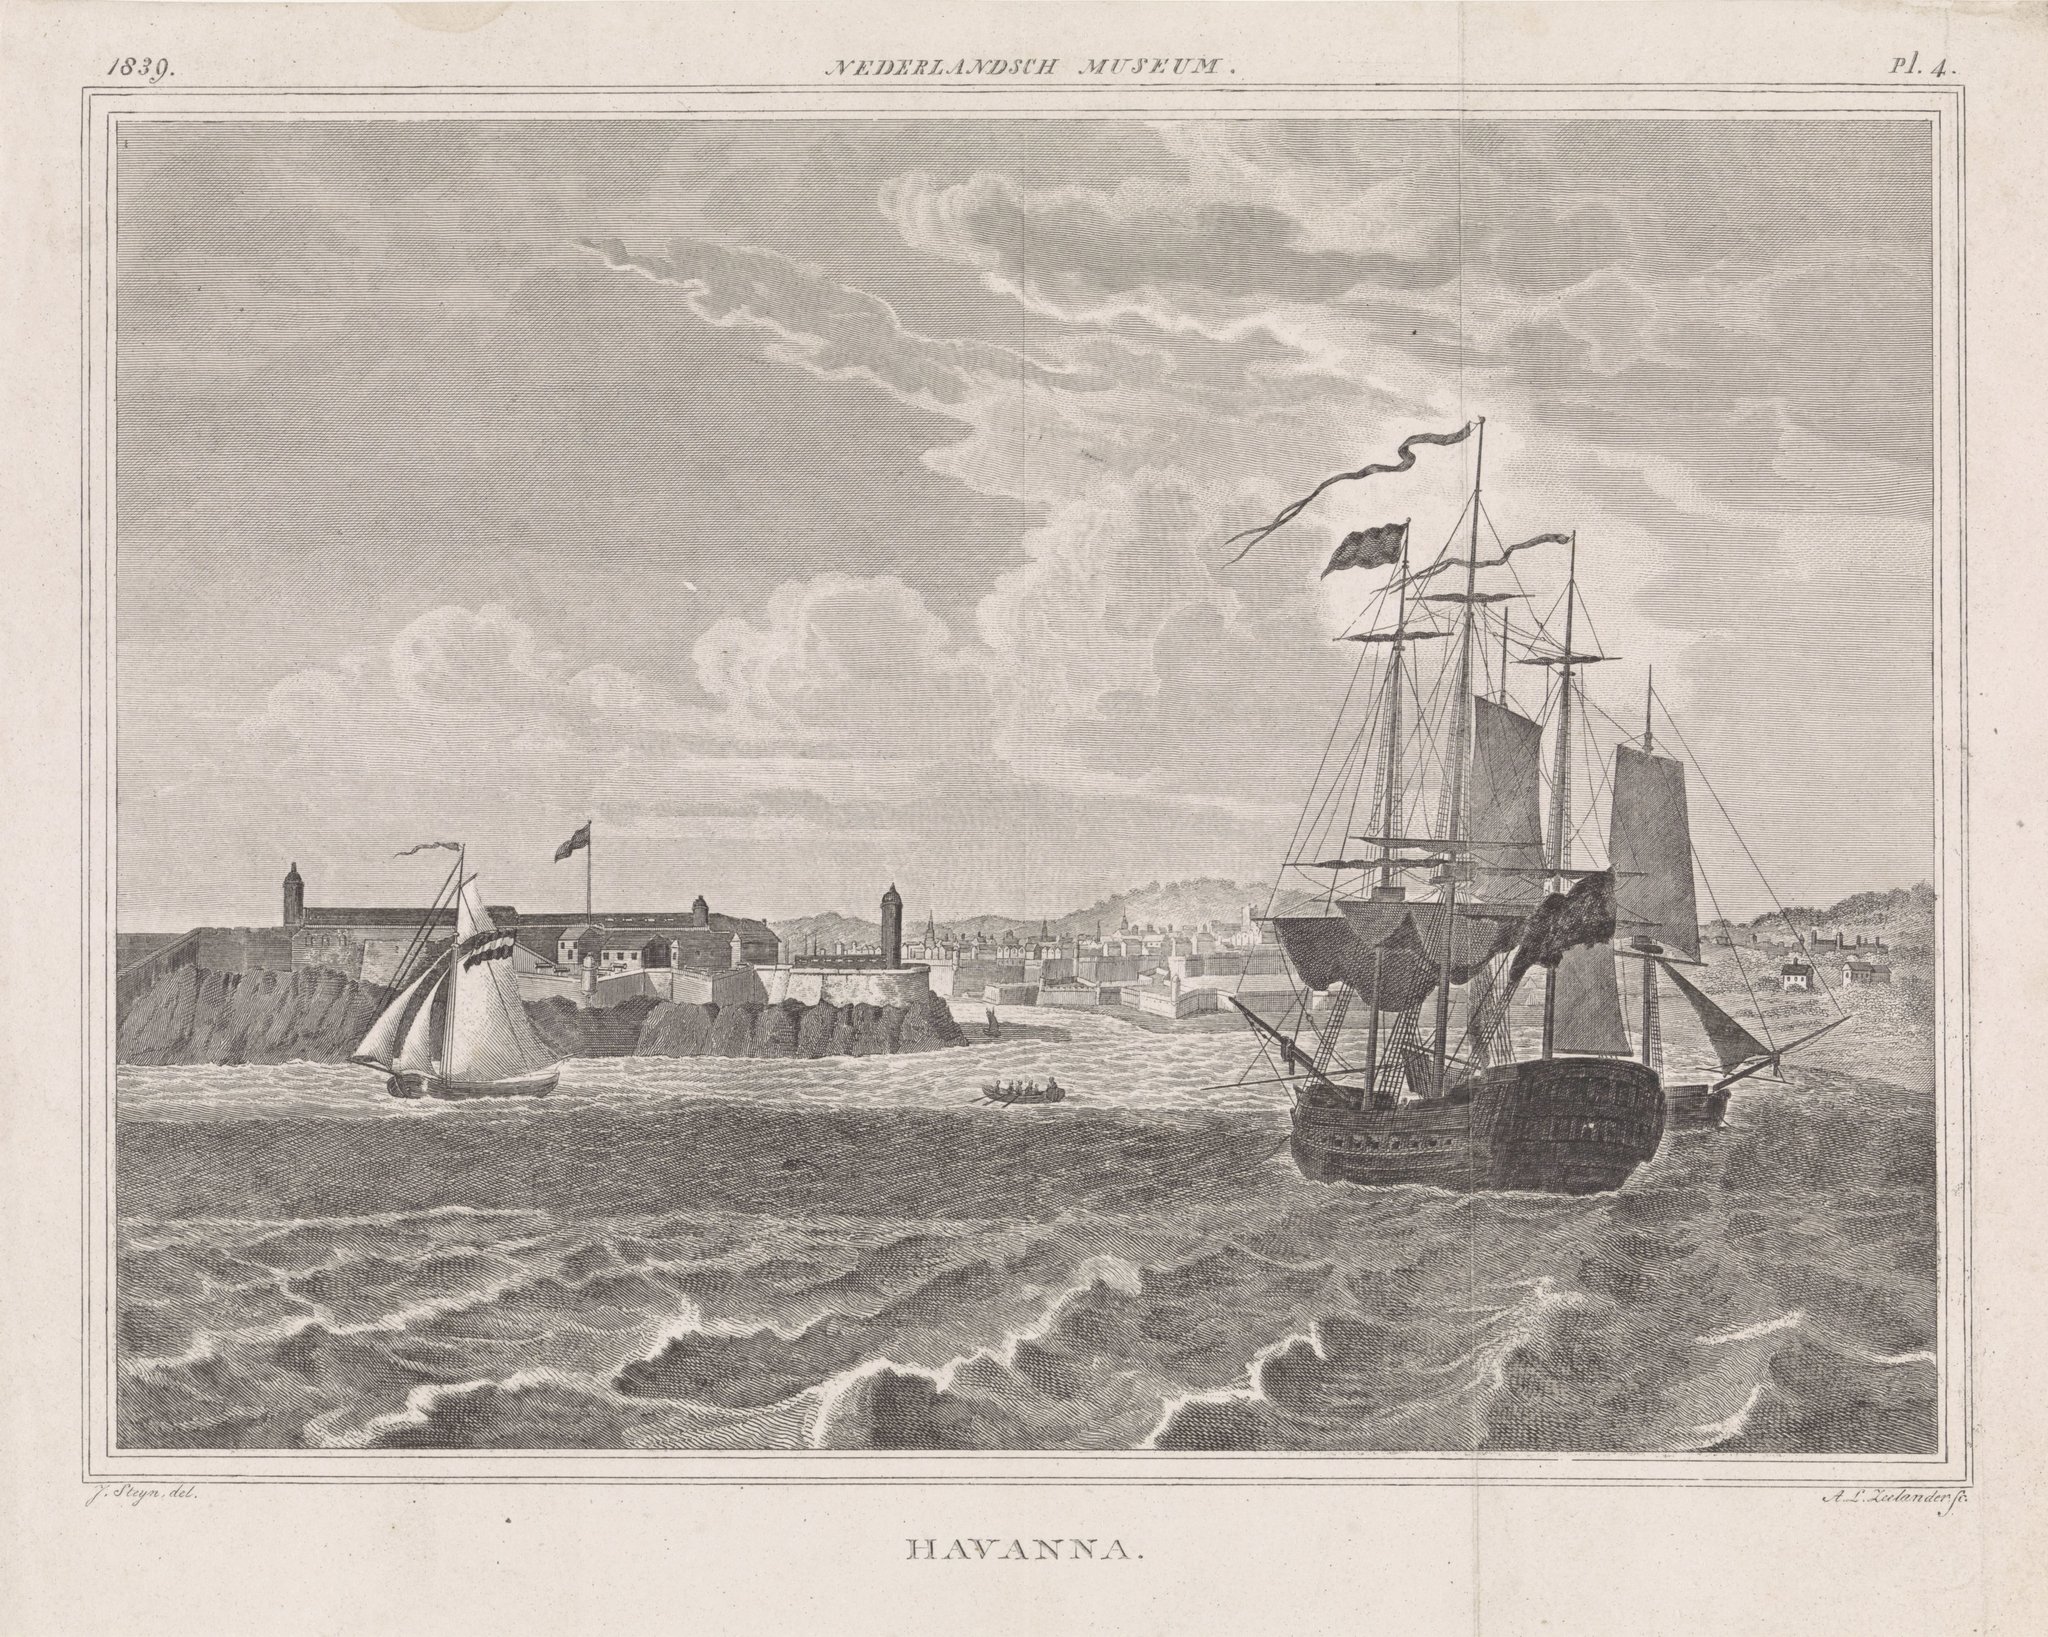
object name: illustration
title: Havanna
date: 1839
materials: paper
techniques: engraving, etching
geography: amsterdam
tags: sailing-ship, sailing-boat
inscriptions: collector's mark: Lugt 2228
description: Illustratie uit het tijdschrift: Nederlandsch museum : geschied- en letterkundige merkwaardigheden, natuurbeschrijvingen, aardrijkskundige bijzonderheden, historische en romantische verhalen : bijeenverzameld uit de pennevruchten van verschillende bekende en anonyme oorspronkelijke schrijvers, alsmede van geleerde en kundige vertalers van de beste stukken uit buitenlandsche periodieken en andere werken. Amsterdam: L. van der Vink, 1839, jrg. 4.